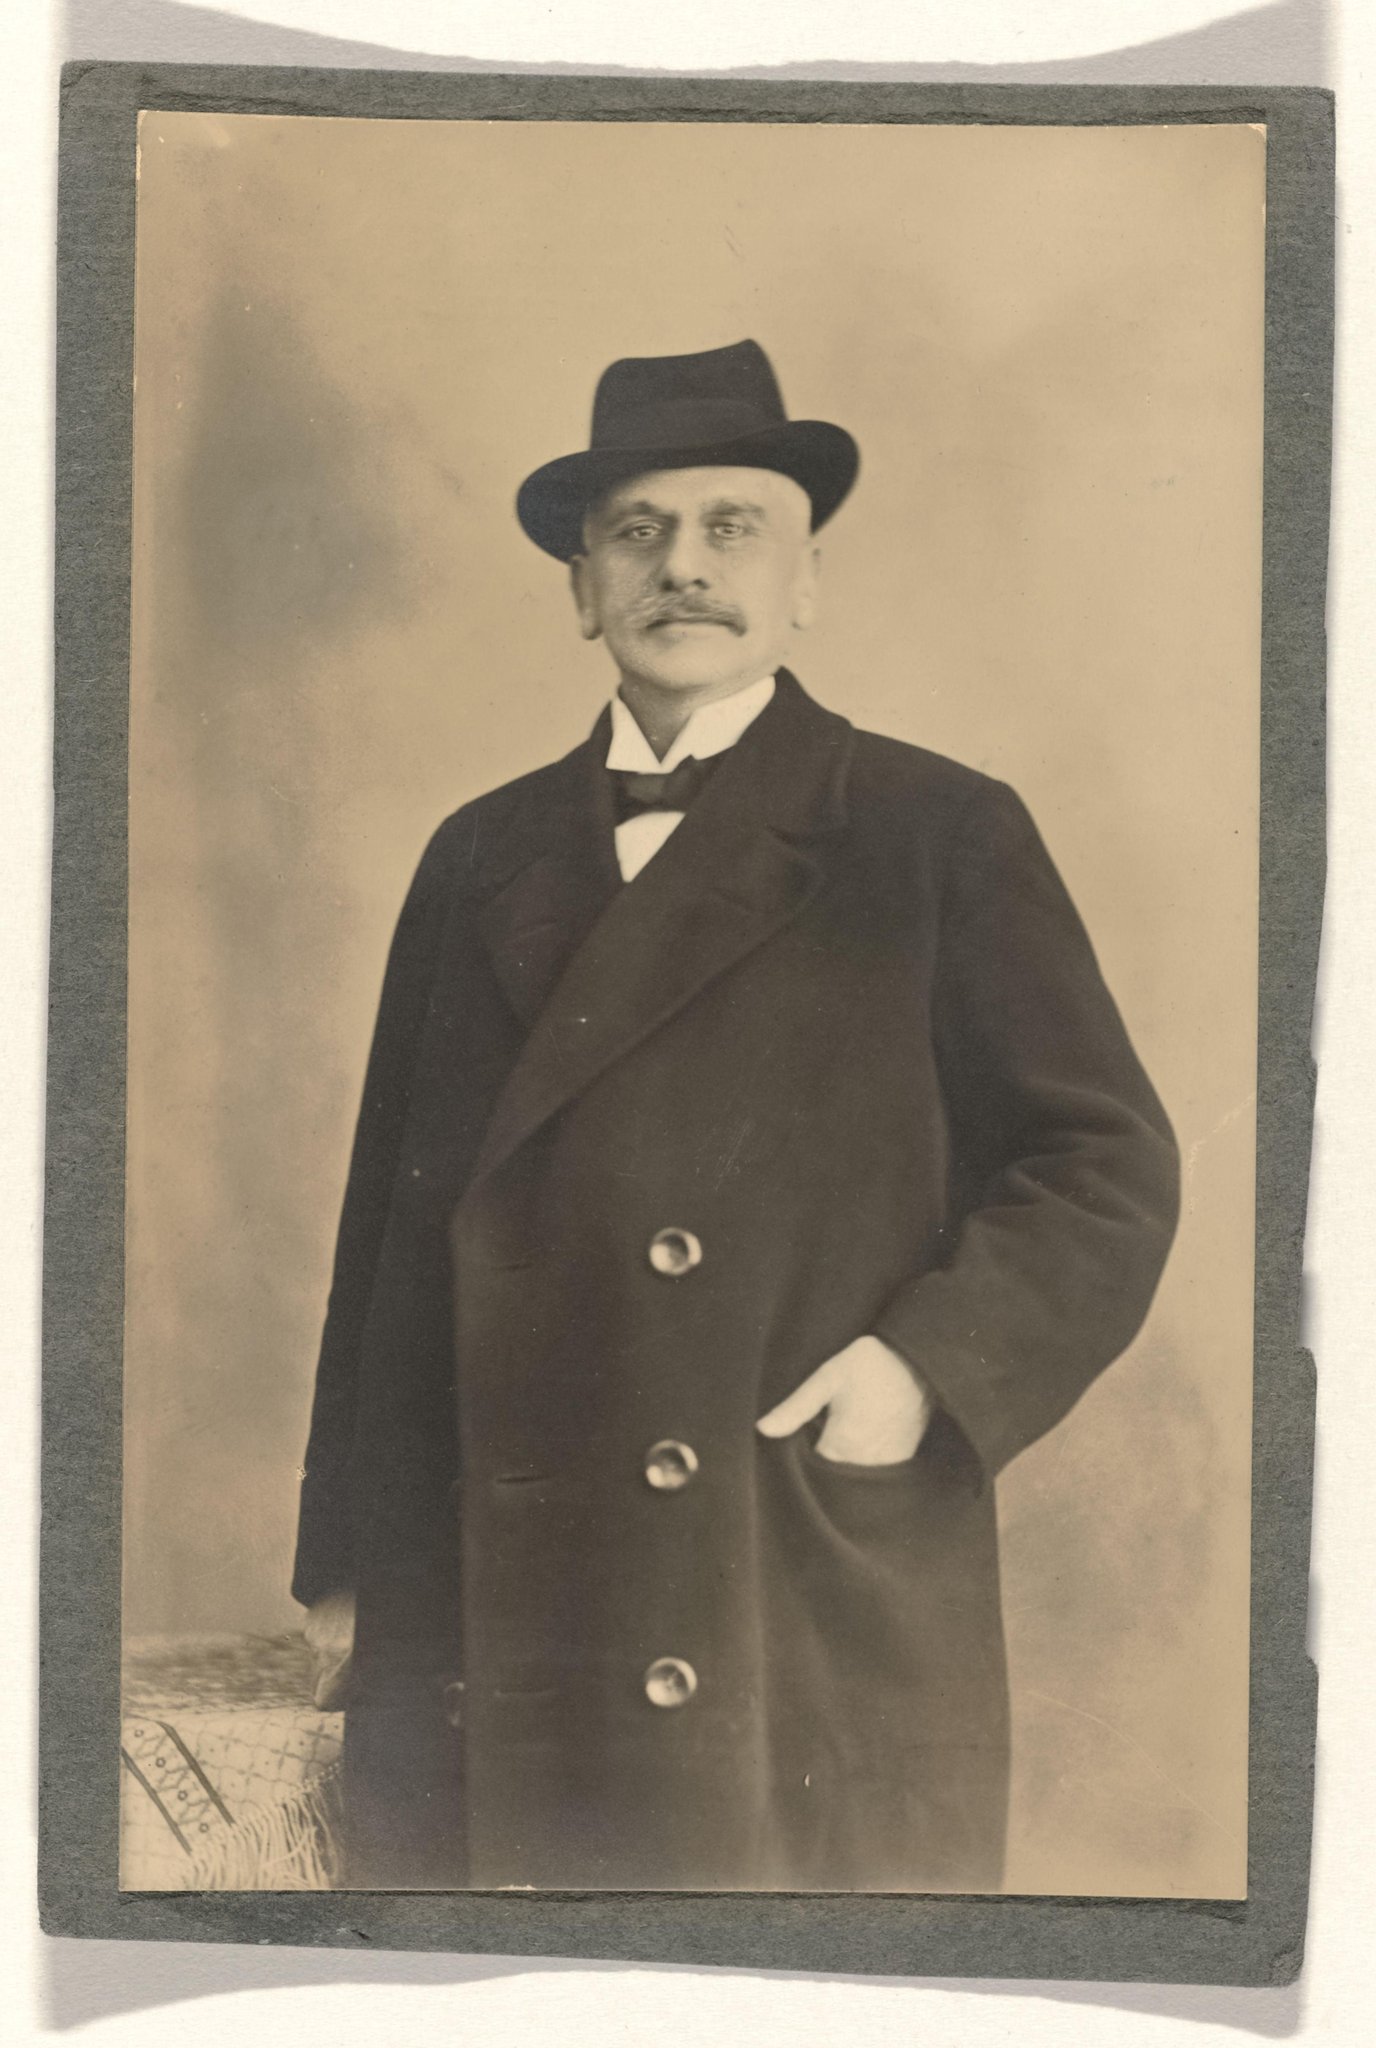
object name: photograph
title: Portret van Meir Wachenheimer, met hoed op het hoofd en hand in de jaszak van een jas met drie knopen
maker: Anonymous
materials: photographic support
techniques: gelatin silver print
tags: meir wachenheimer, straatsburg (frankrijk)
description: Portret van Meir Wachenheimer, met hoed op het hoofd en hand in de jaszak van een jas met drie knopen.